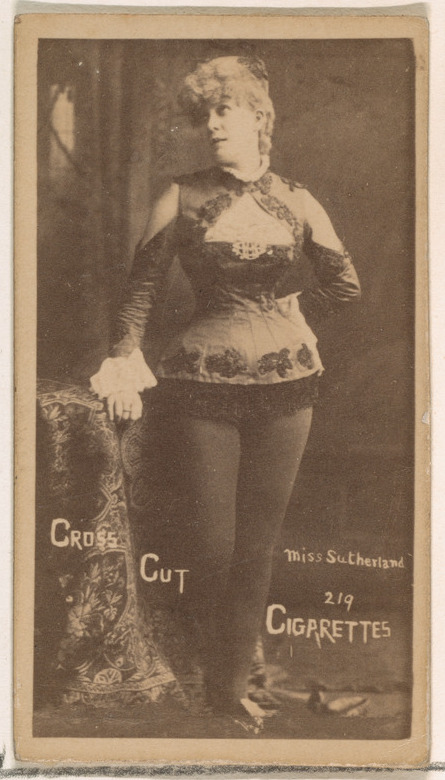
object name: print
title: Card Number 219, Sutherland, from the Actors and Actresses series (N145-1) issued by Duke Sons & Co. to promote Cross Cut Cigarettes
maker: w. duke, sons & co.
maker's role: publisher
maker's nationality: american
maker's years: 1870-1920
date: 1880-1889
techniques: albumen silver print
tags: portraits,women,actresses